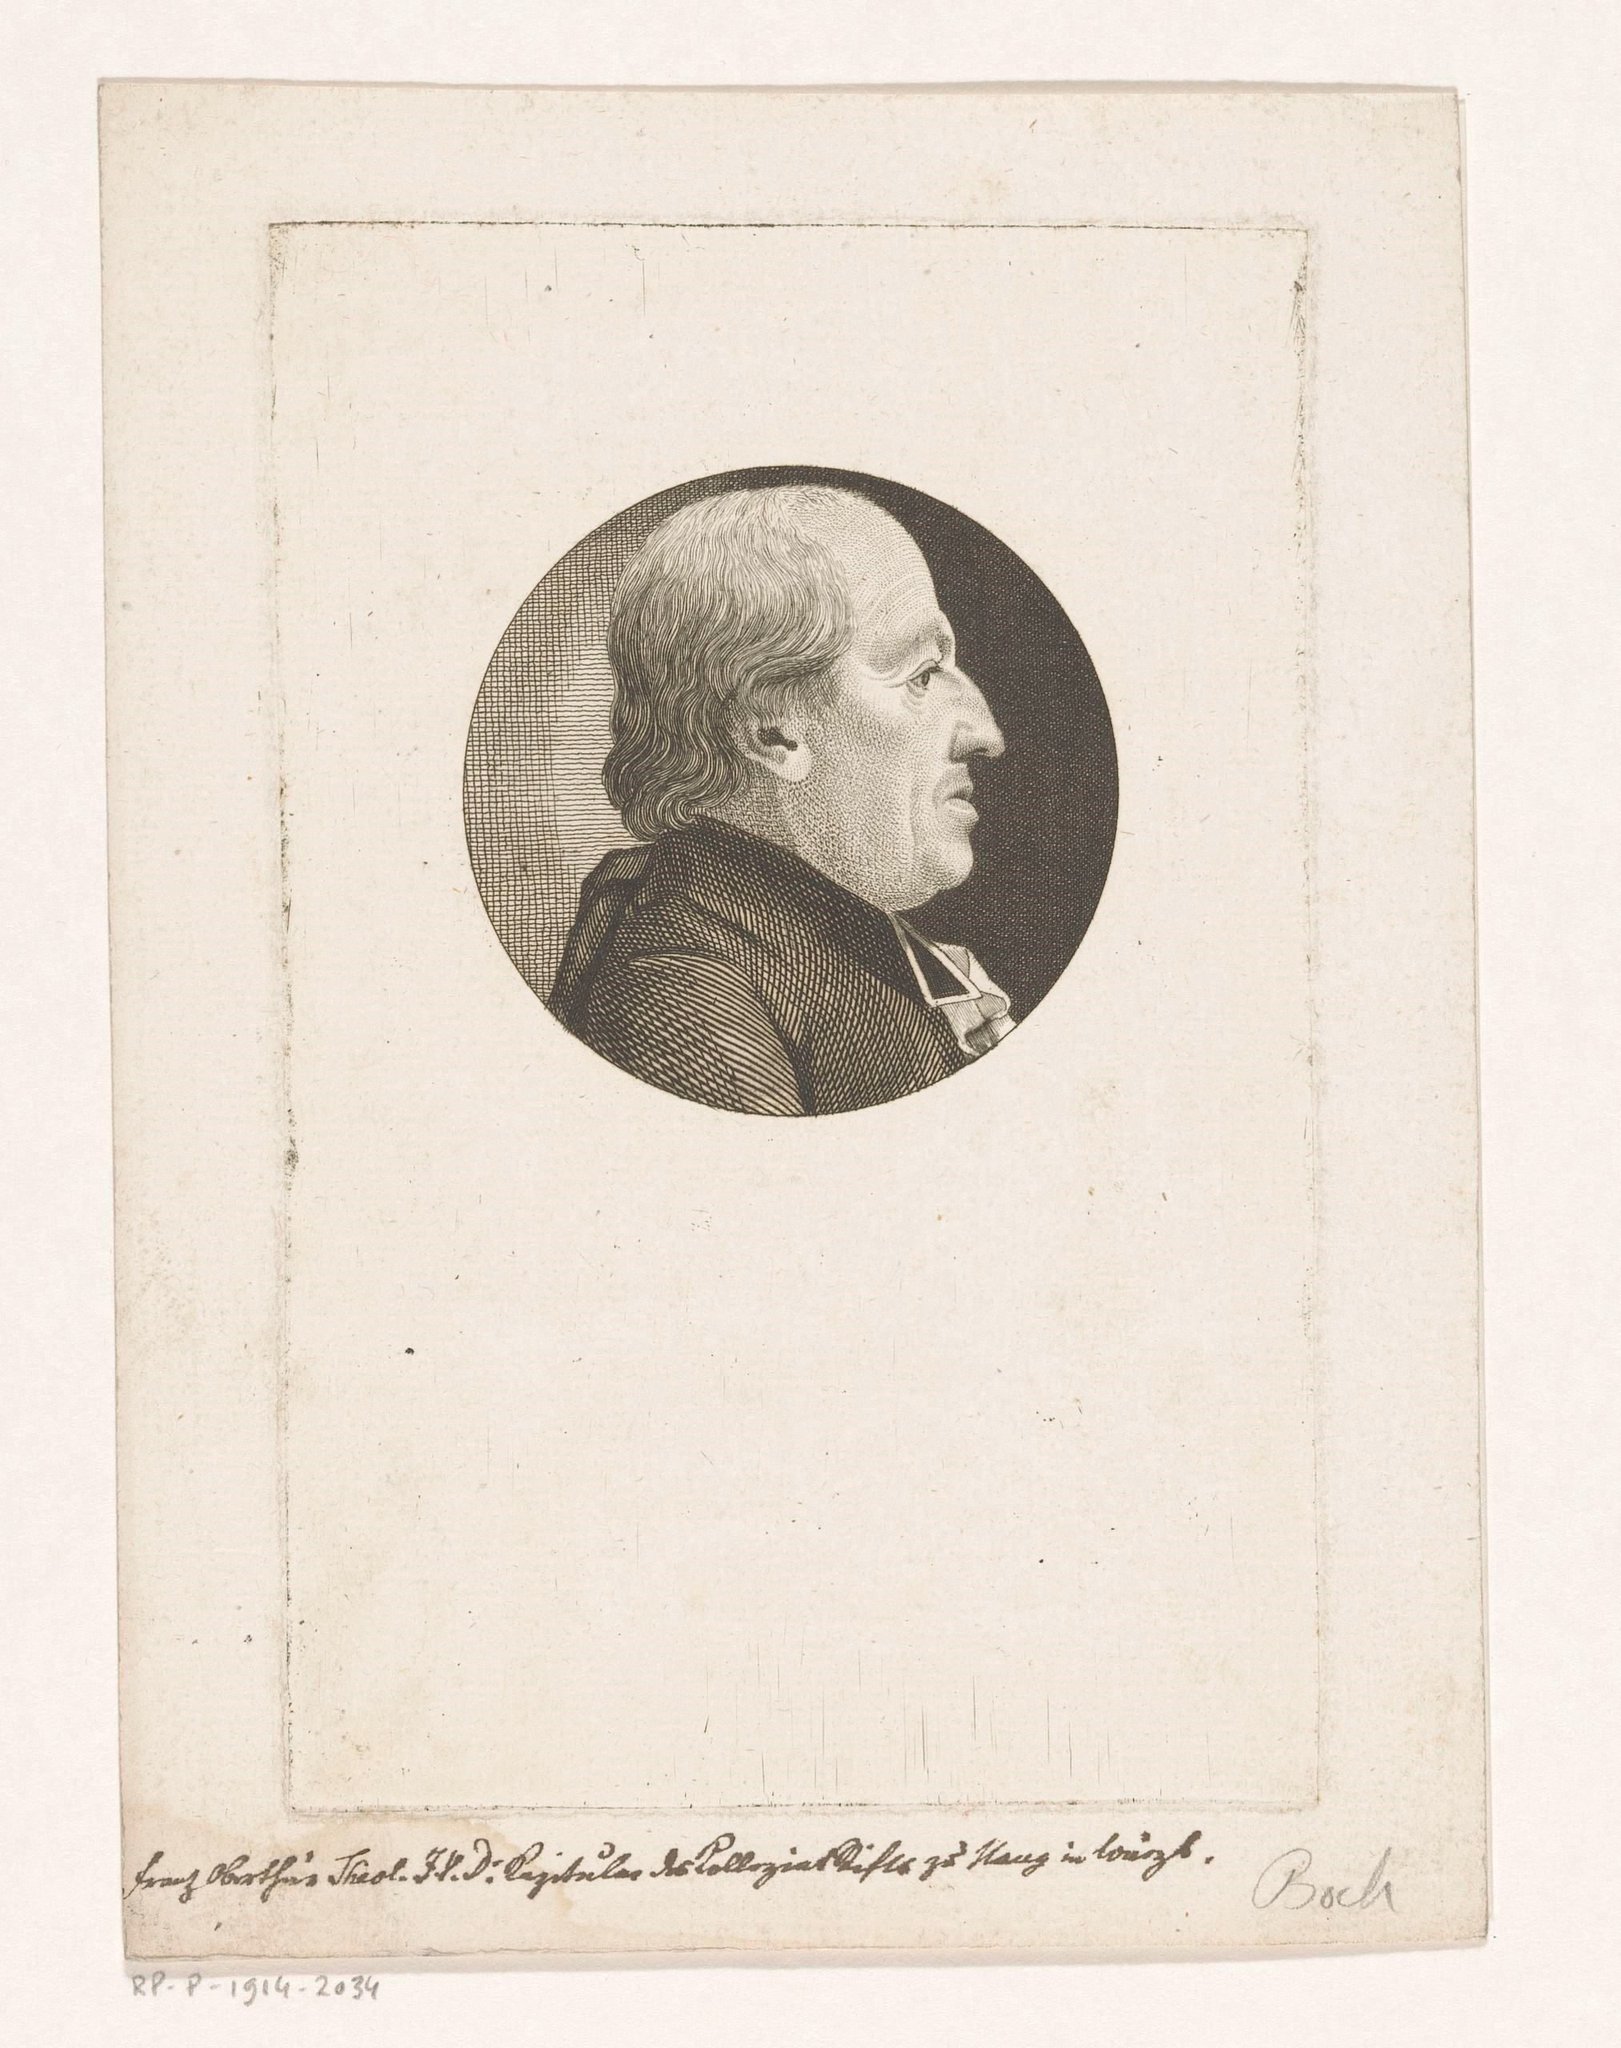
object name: print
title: Portret van Franz Oberthür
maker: christoph wilhelm bock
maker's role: print maker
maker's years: 1755-1836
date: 1795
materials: paper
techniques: engraving, etching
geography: stuttgart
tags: historical persons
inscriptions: collector's mark: Lugt 2228